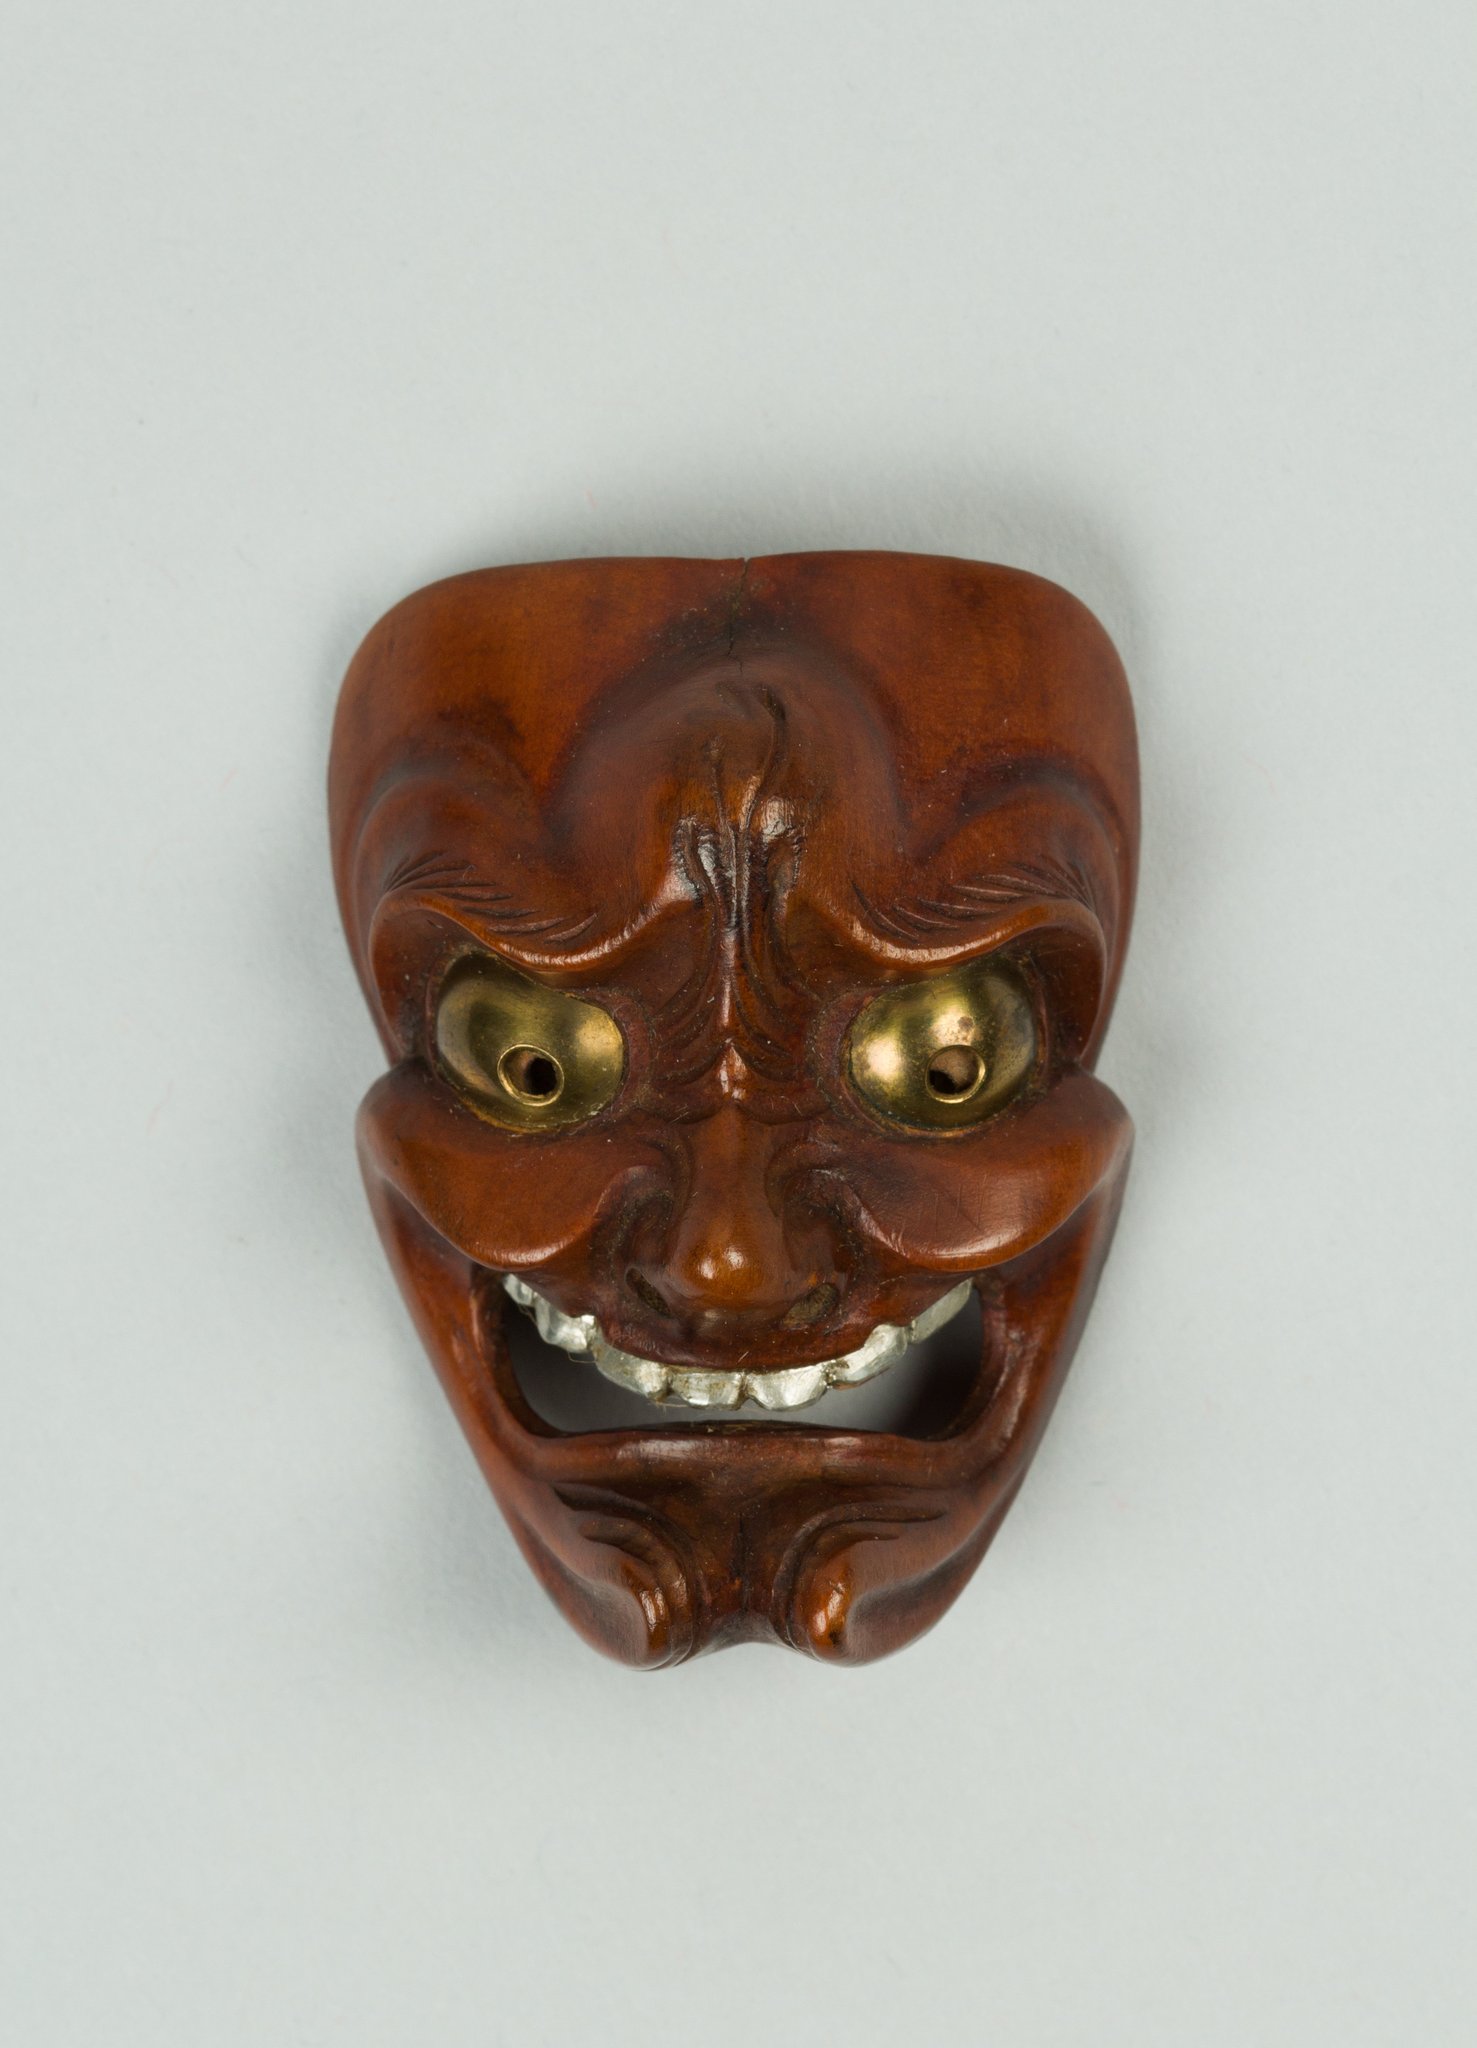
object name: netsuke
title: Netsuke of Mask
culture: japanese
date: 1801-1900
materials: brass, lead, wood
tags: masks